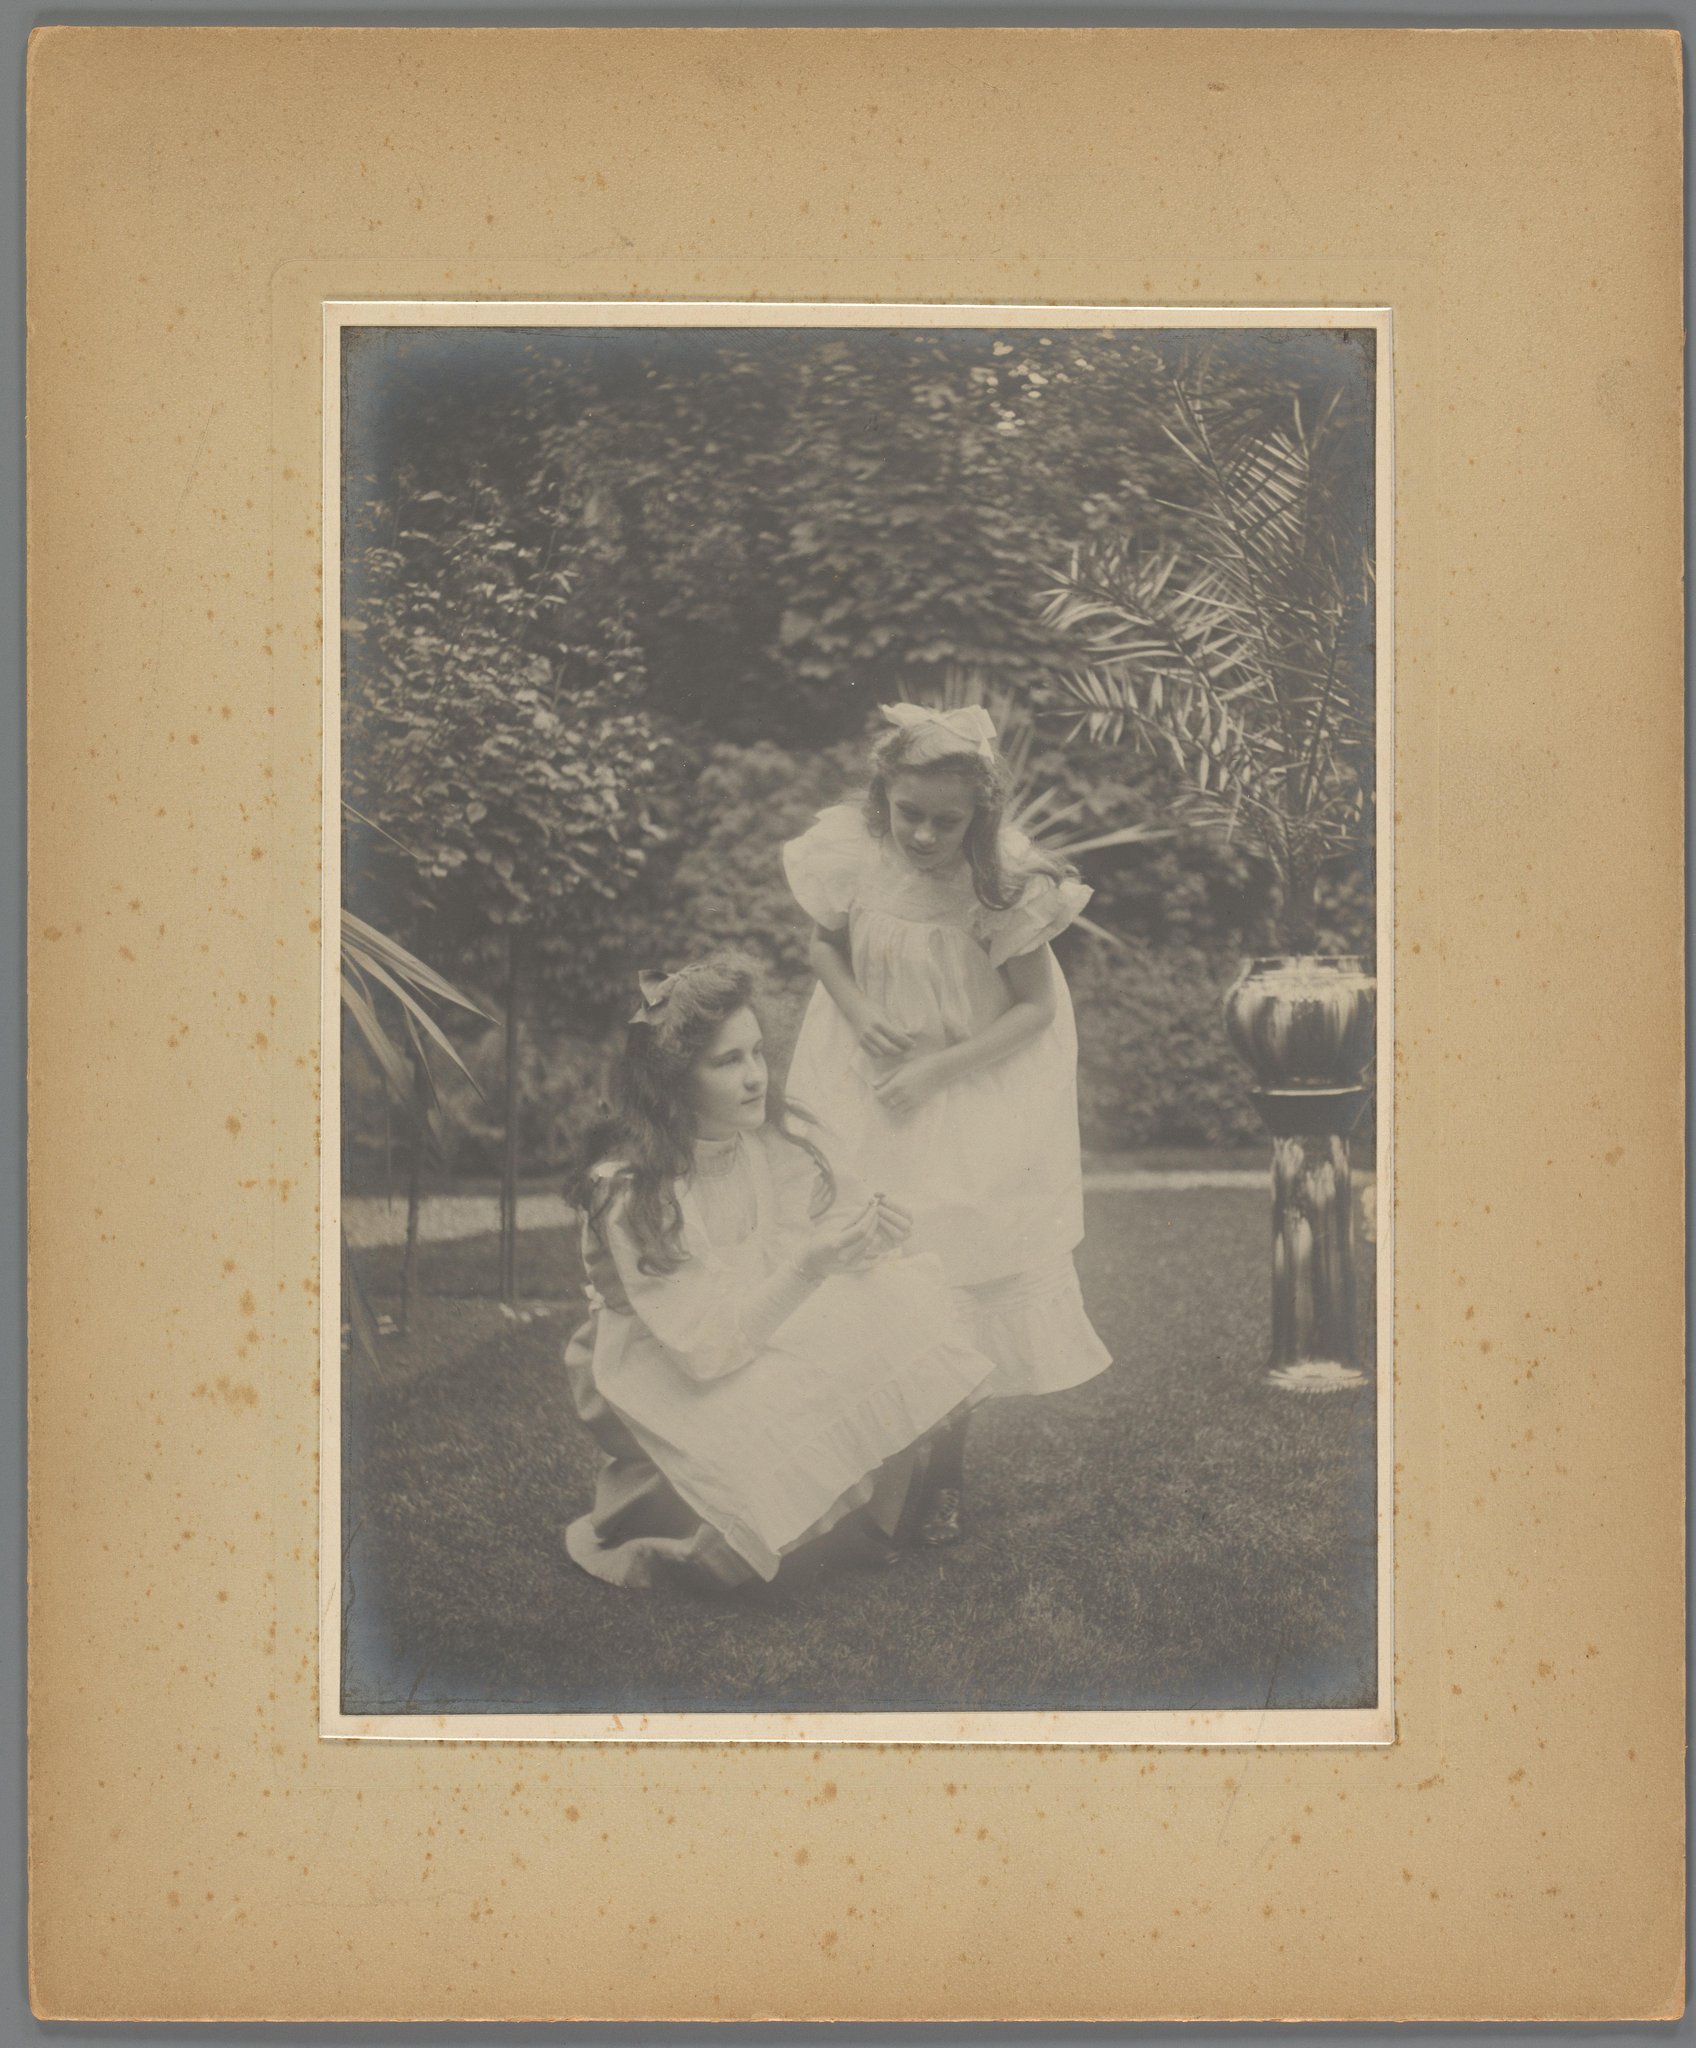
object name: photograph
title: Johanna (Hans) de Jong en Johanna (Nan) Vreede in de tuin van Piet en Hendrina (Dina) de Jong in Arnhem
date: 1905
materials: paper, cardboard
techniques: gelatin silver print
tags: johanna petronella lambertina stokhuyzen-de jong (hans), surabaya, johanna elisabeth borgerhoff mulder-vreede (nan), garden, historical persons, girl (child between toddler and youth)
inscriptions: inscription: ‘H + Nan’